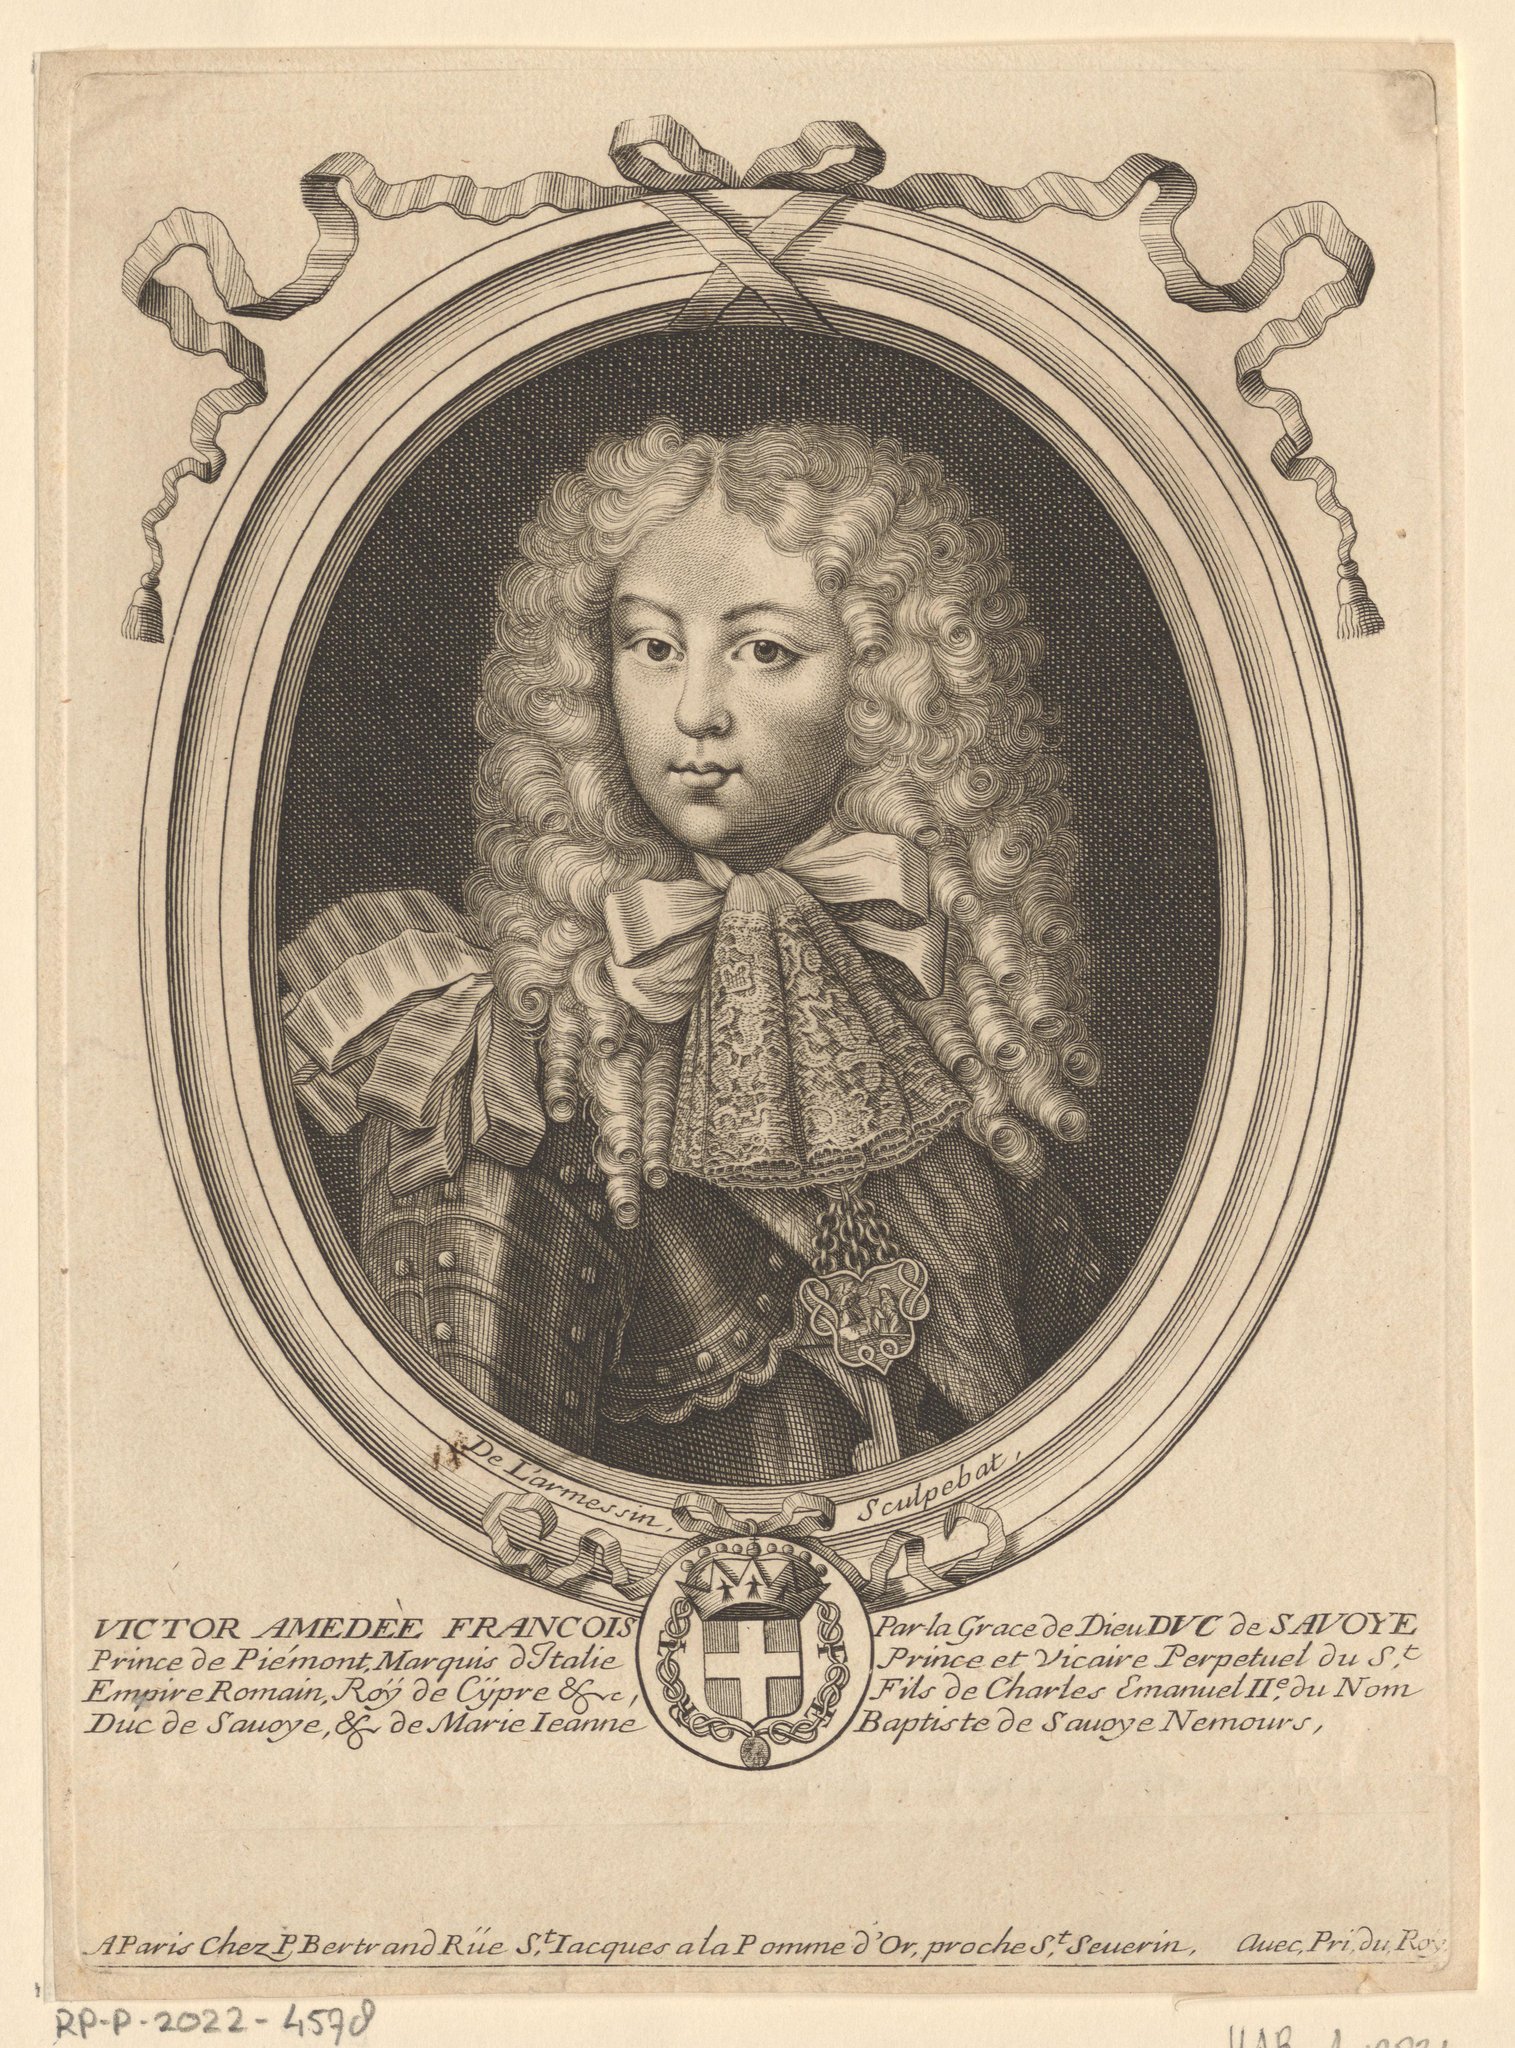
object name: print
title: Portret van Victor Amadeus II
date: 1675-1678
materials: paper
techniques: engraving, etching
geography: france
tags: historical persons, ruler, sovereign